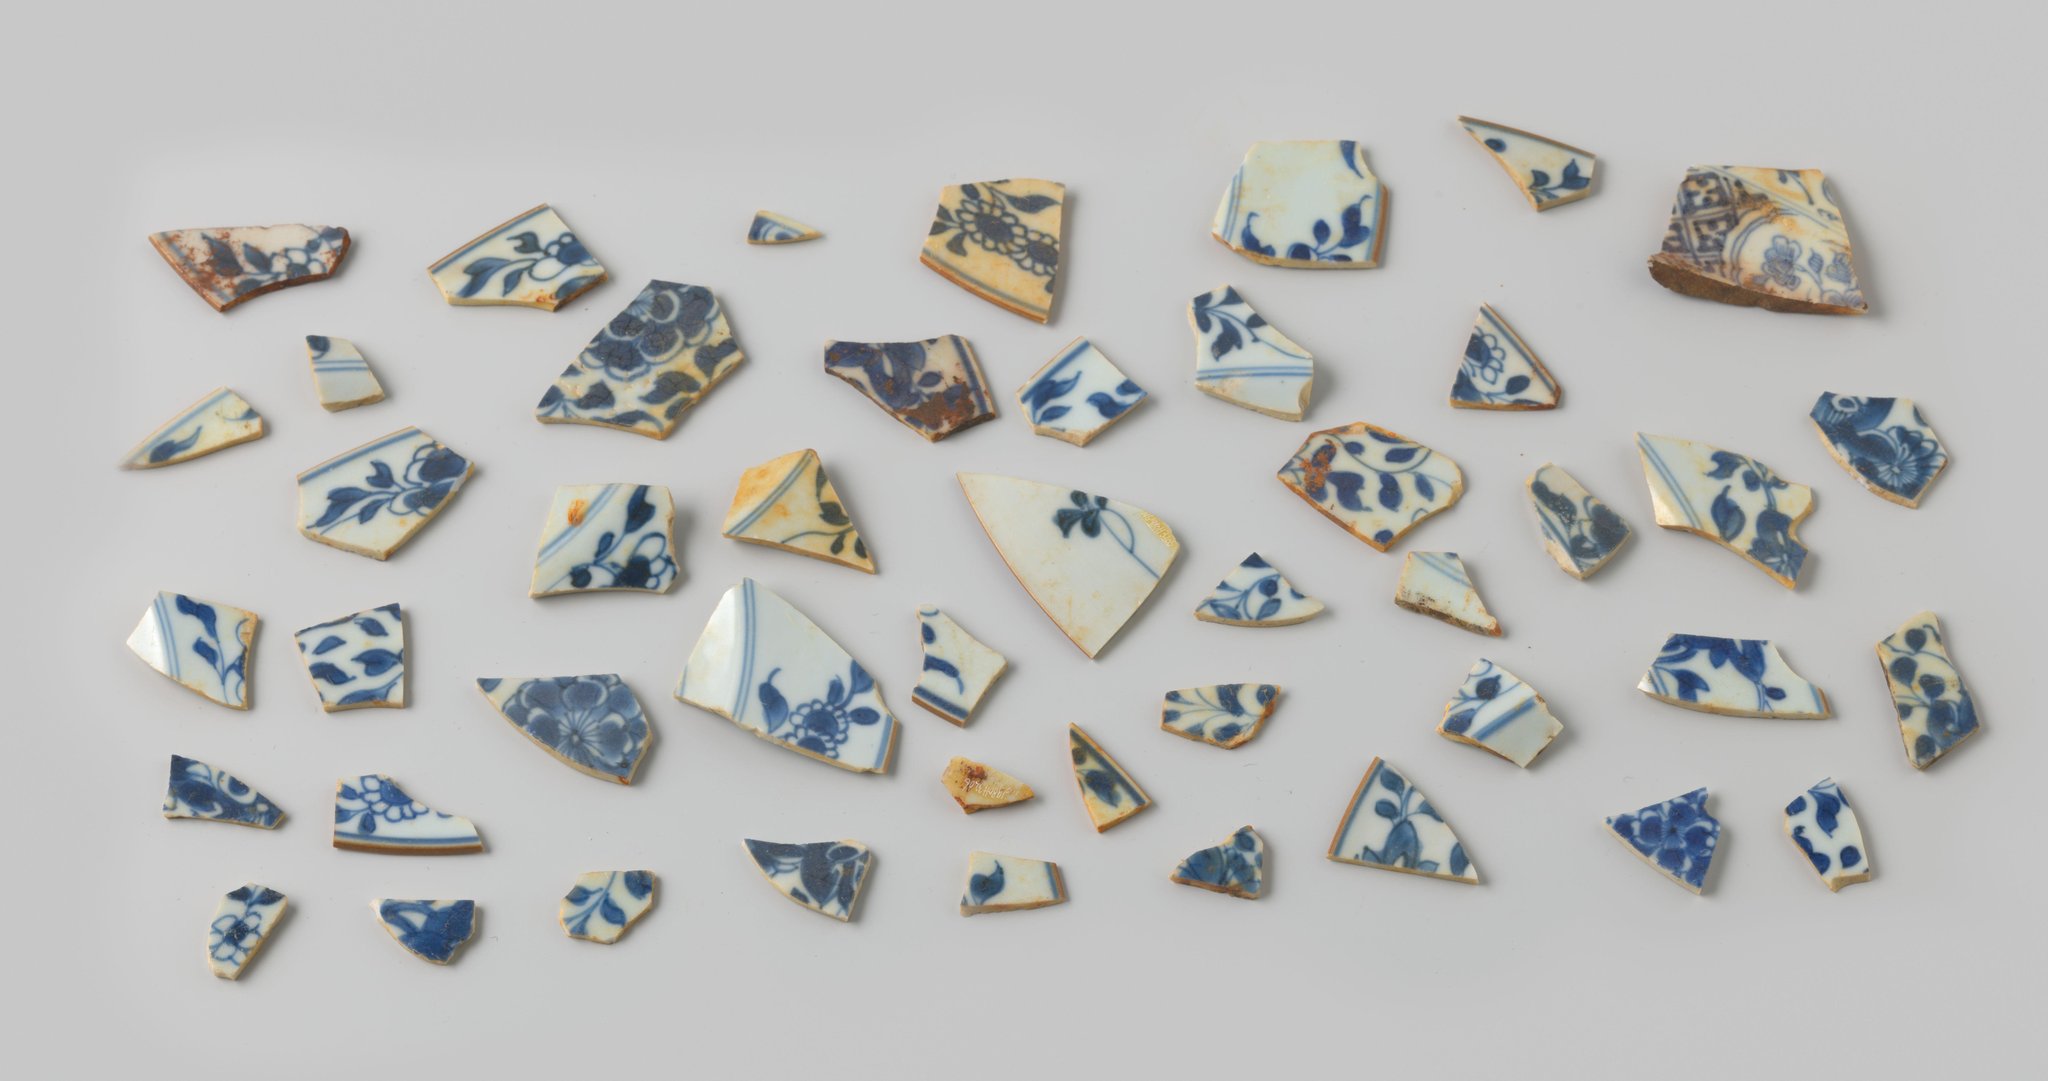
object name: plate dish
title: Scherven van schotels uit het wrak van de Oost-Indiëvaarder Hollandia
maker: Anonymous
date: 1700-1743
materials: porcelain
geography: netherlands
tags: verenigde oostindische compagnie, hollandia (schip), annet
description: Porcelain, dish, saucer, fragments; fragm of bases and rims.